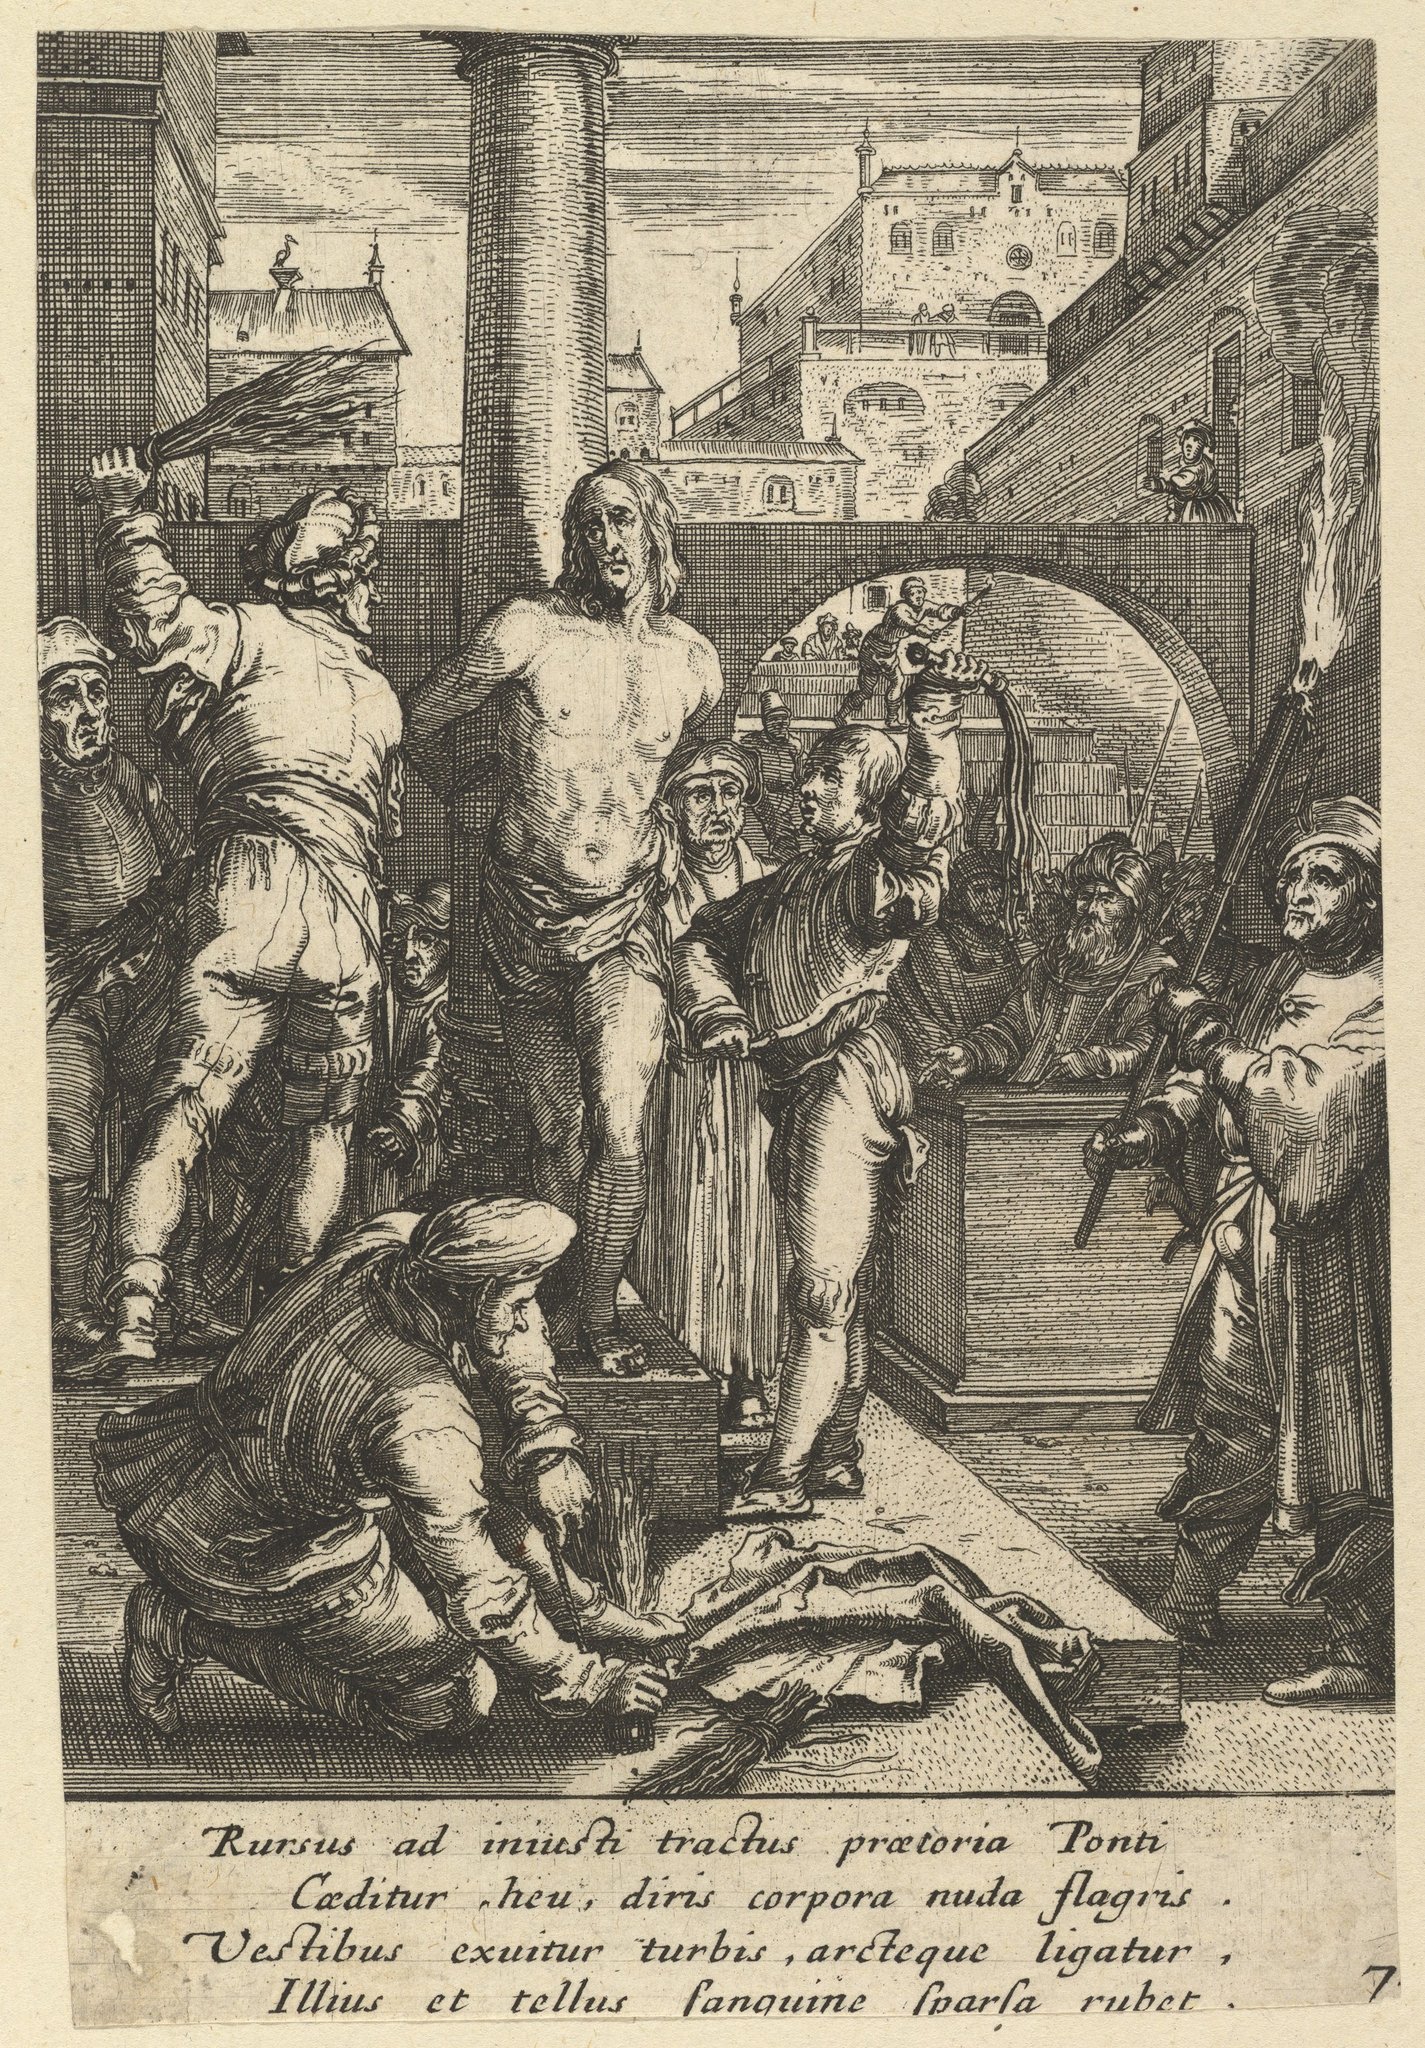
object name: print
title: The Flagellation of Christ, from "The Passion of Christ"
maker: nicolas cochin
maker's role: artist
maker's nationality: french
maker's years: 1610-1686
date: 1634-1666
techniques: etching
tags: men,christ